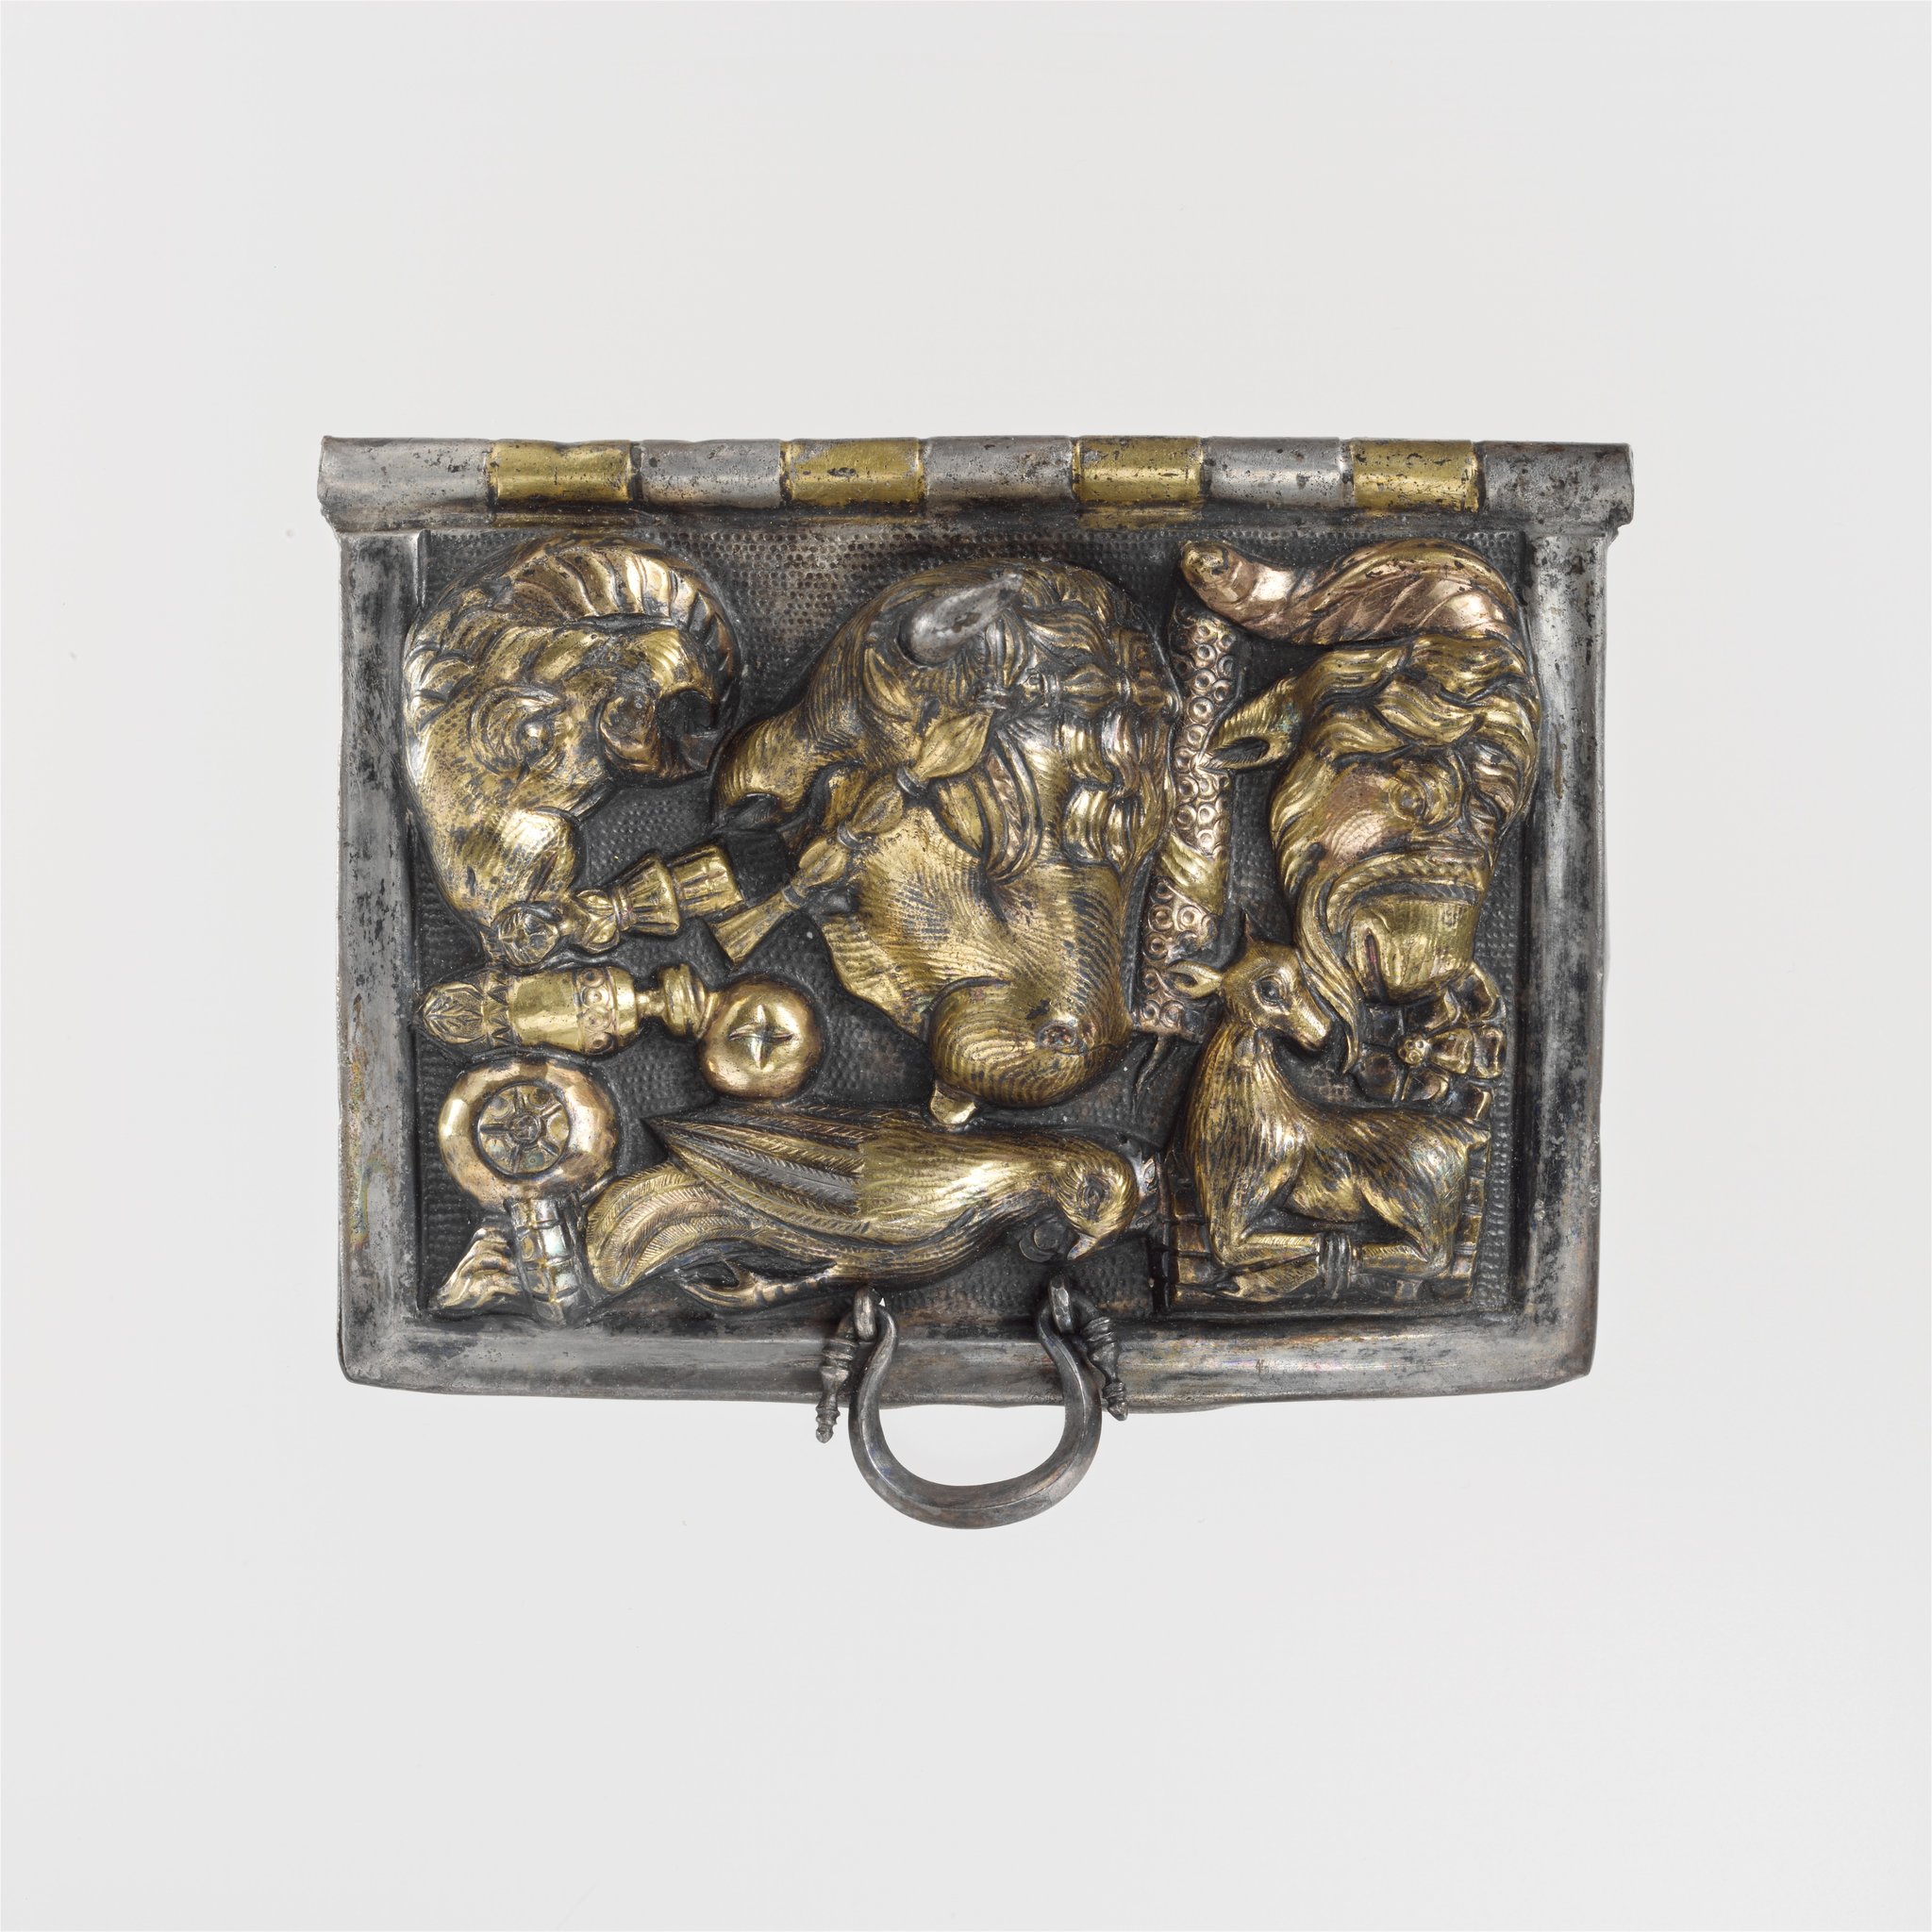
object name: lid of box, silver gilt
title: Gilt-silver ceremonial box lid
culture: roman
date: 67-100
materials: silver gilt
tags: birds,bulls,goats,rams